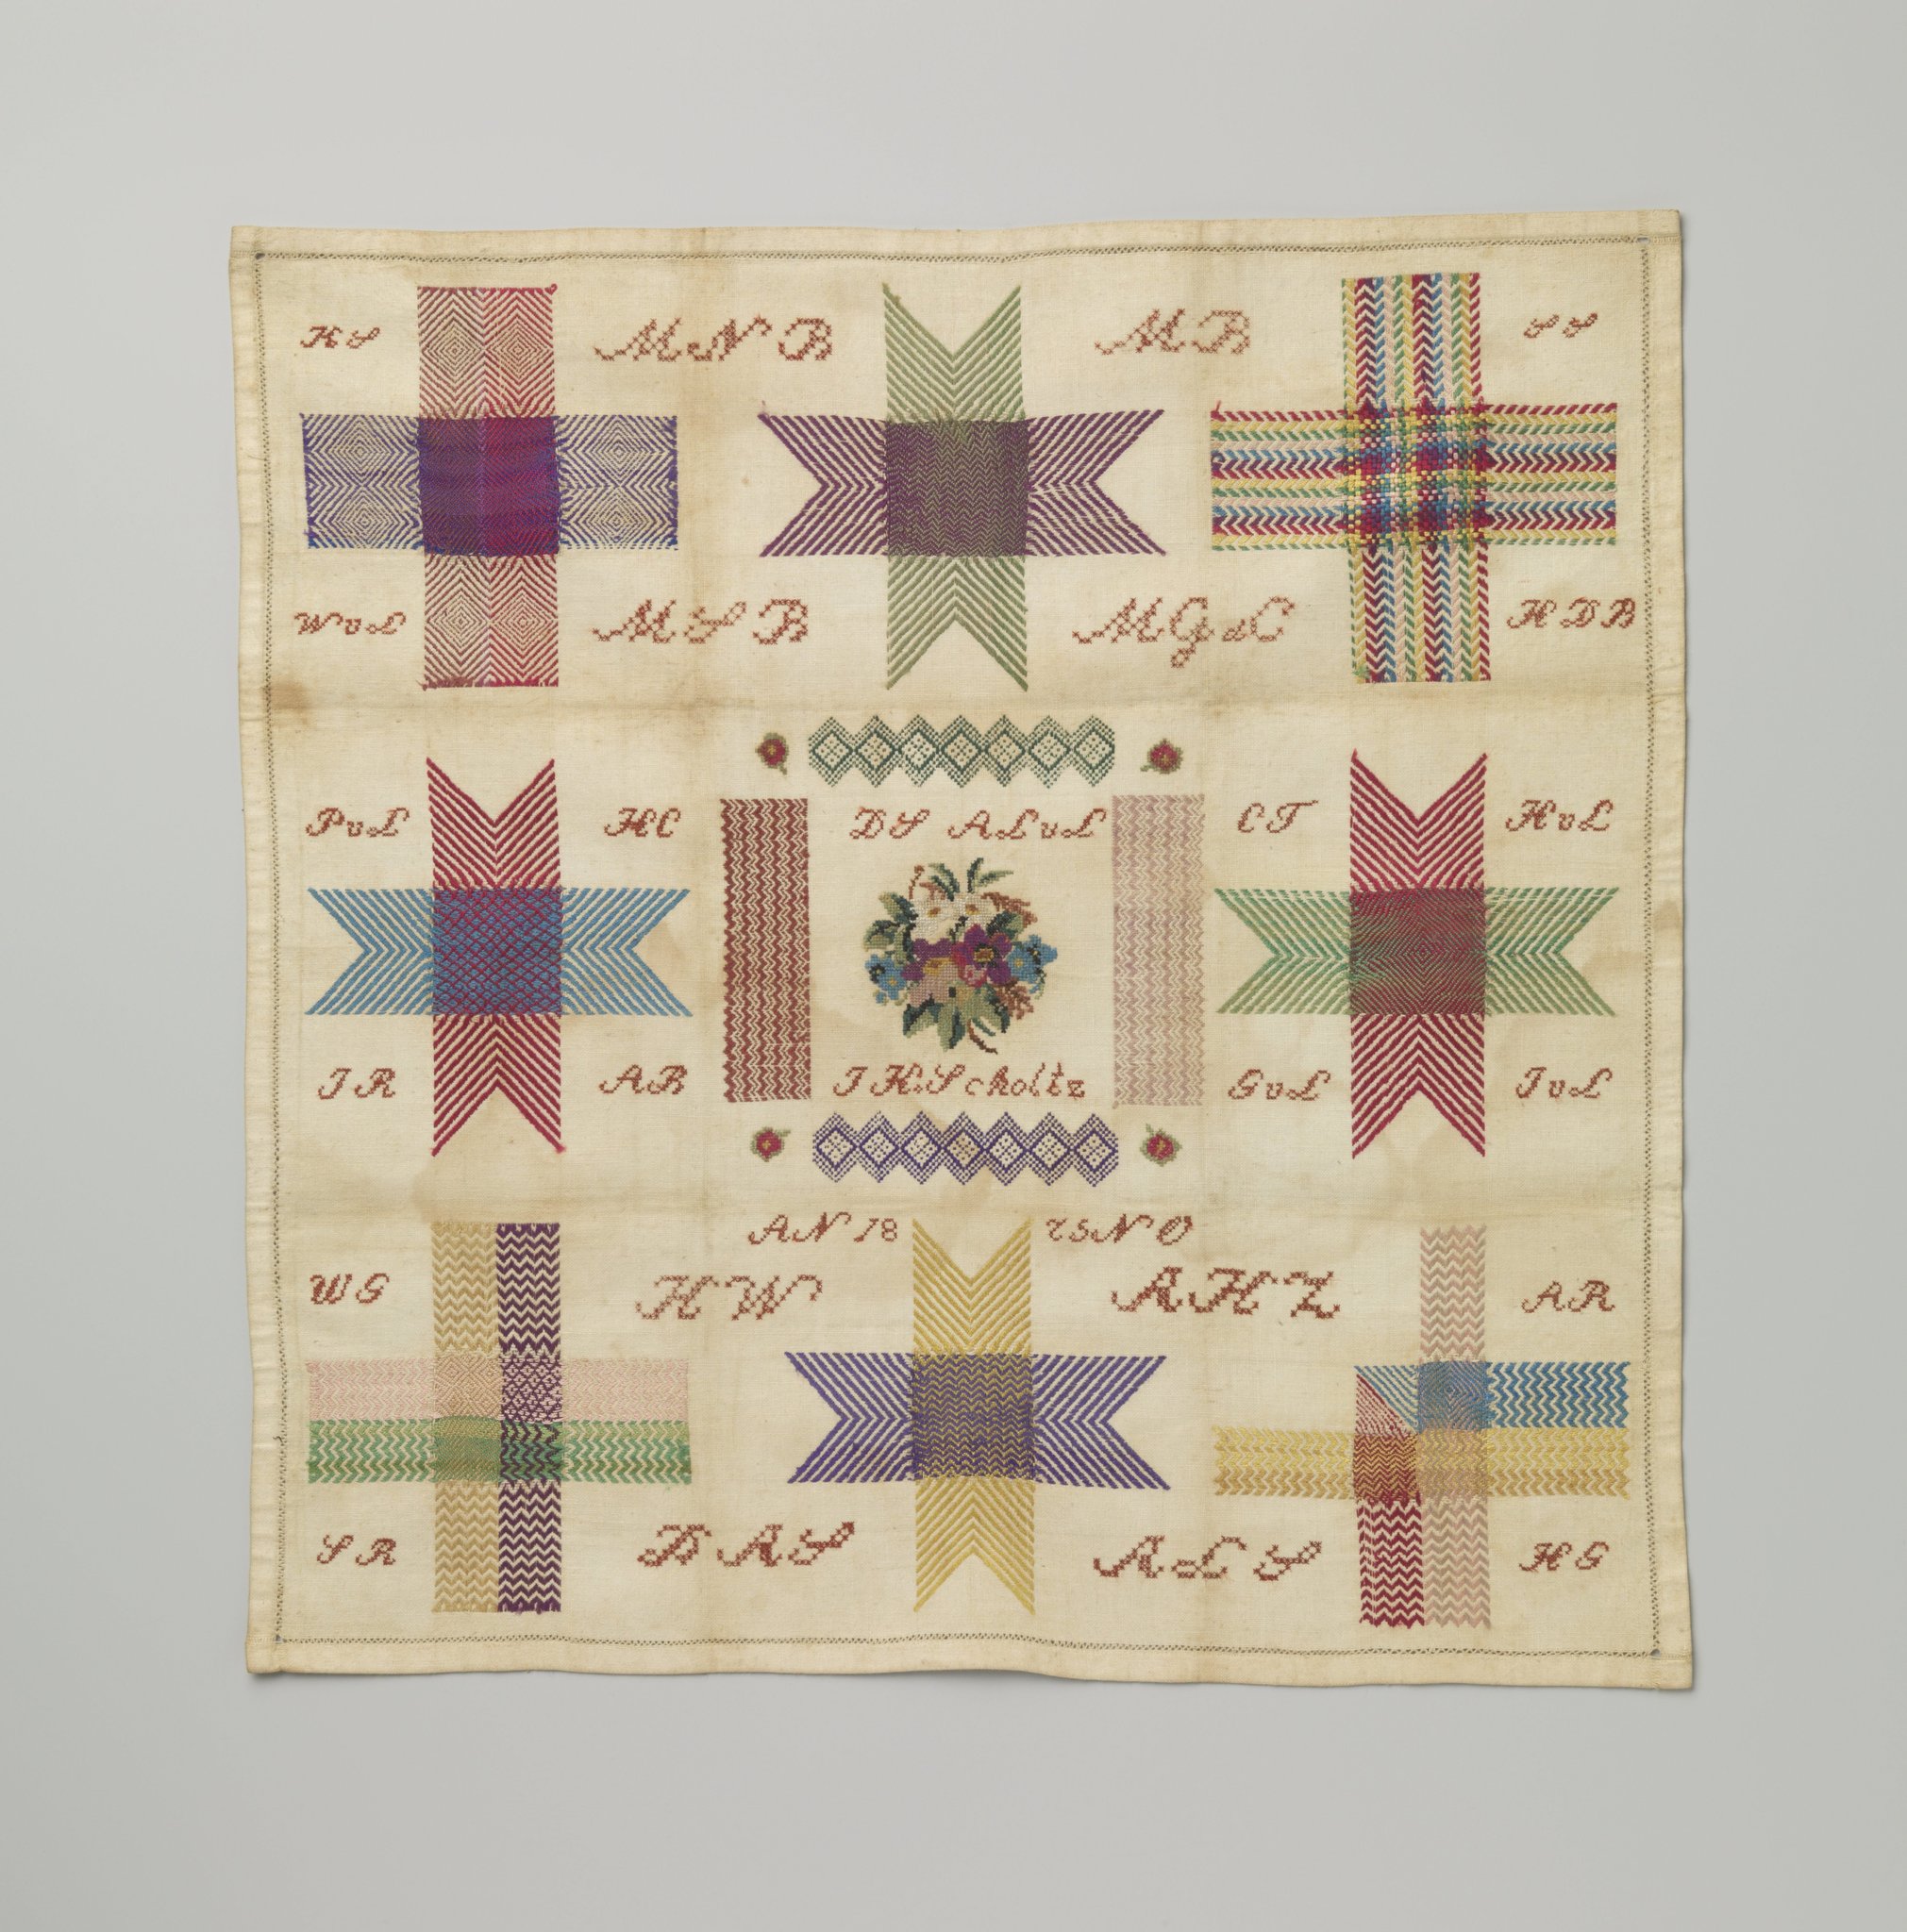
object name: stoplap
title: Stoplap van veelkleurige zijde op katoen.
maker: johanna hendrika scholtz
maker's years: 1861-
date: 1875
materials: cotton, silk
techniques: embroidered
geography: dutch reformed diaconie orphanage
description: Stoplap van zijde op katoen. Het borduurwerk bestaat uit de initialen en letters JH SCHOLTZ, ANNO 1875, DS, ALvL, vier sterren (Nederduits Hervormde Diakonie), in het midden een boeket en rozen in de hoeken.